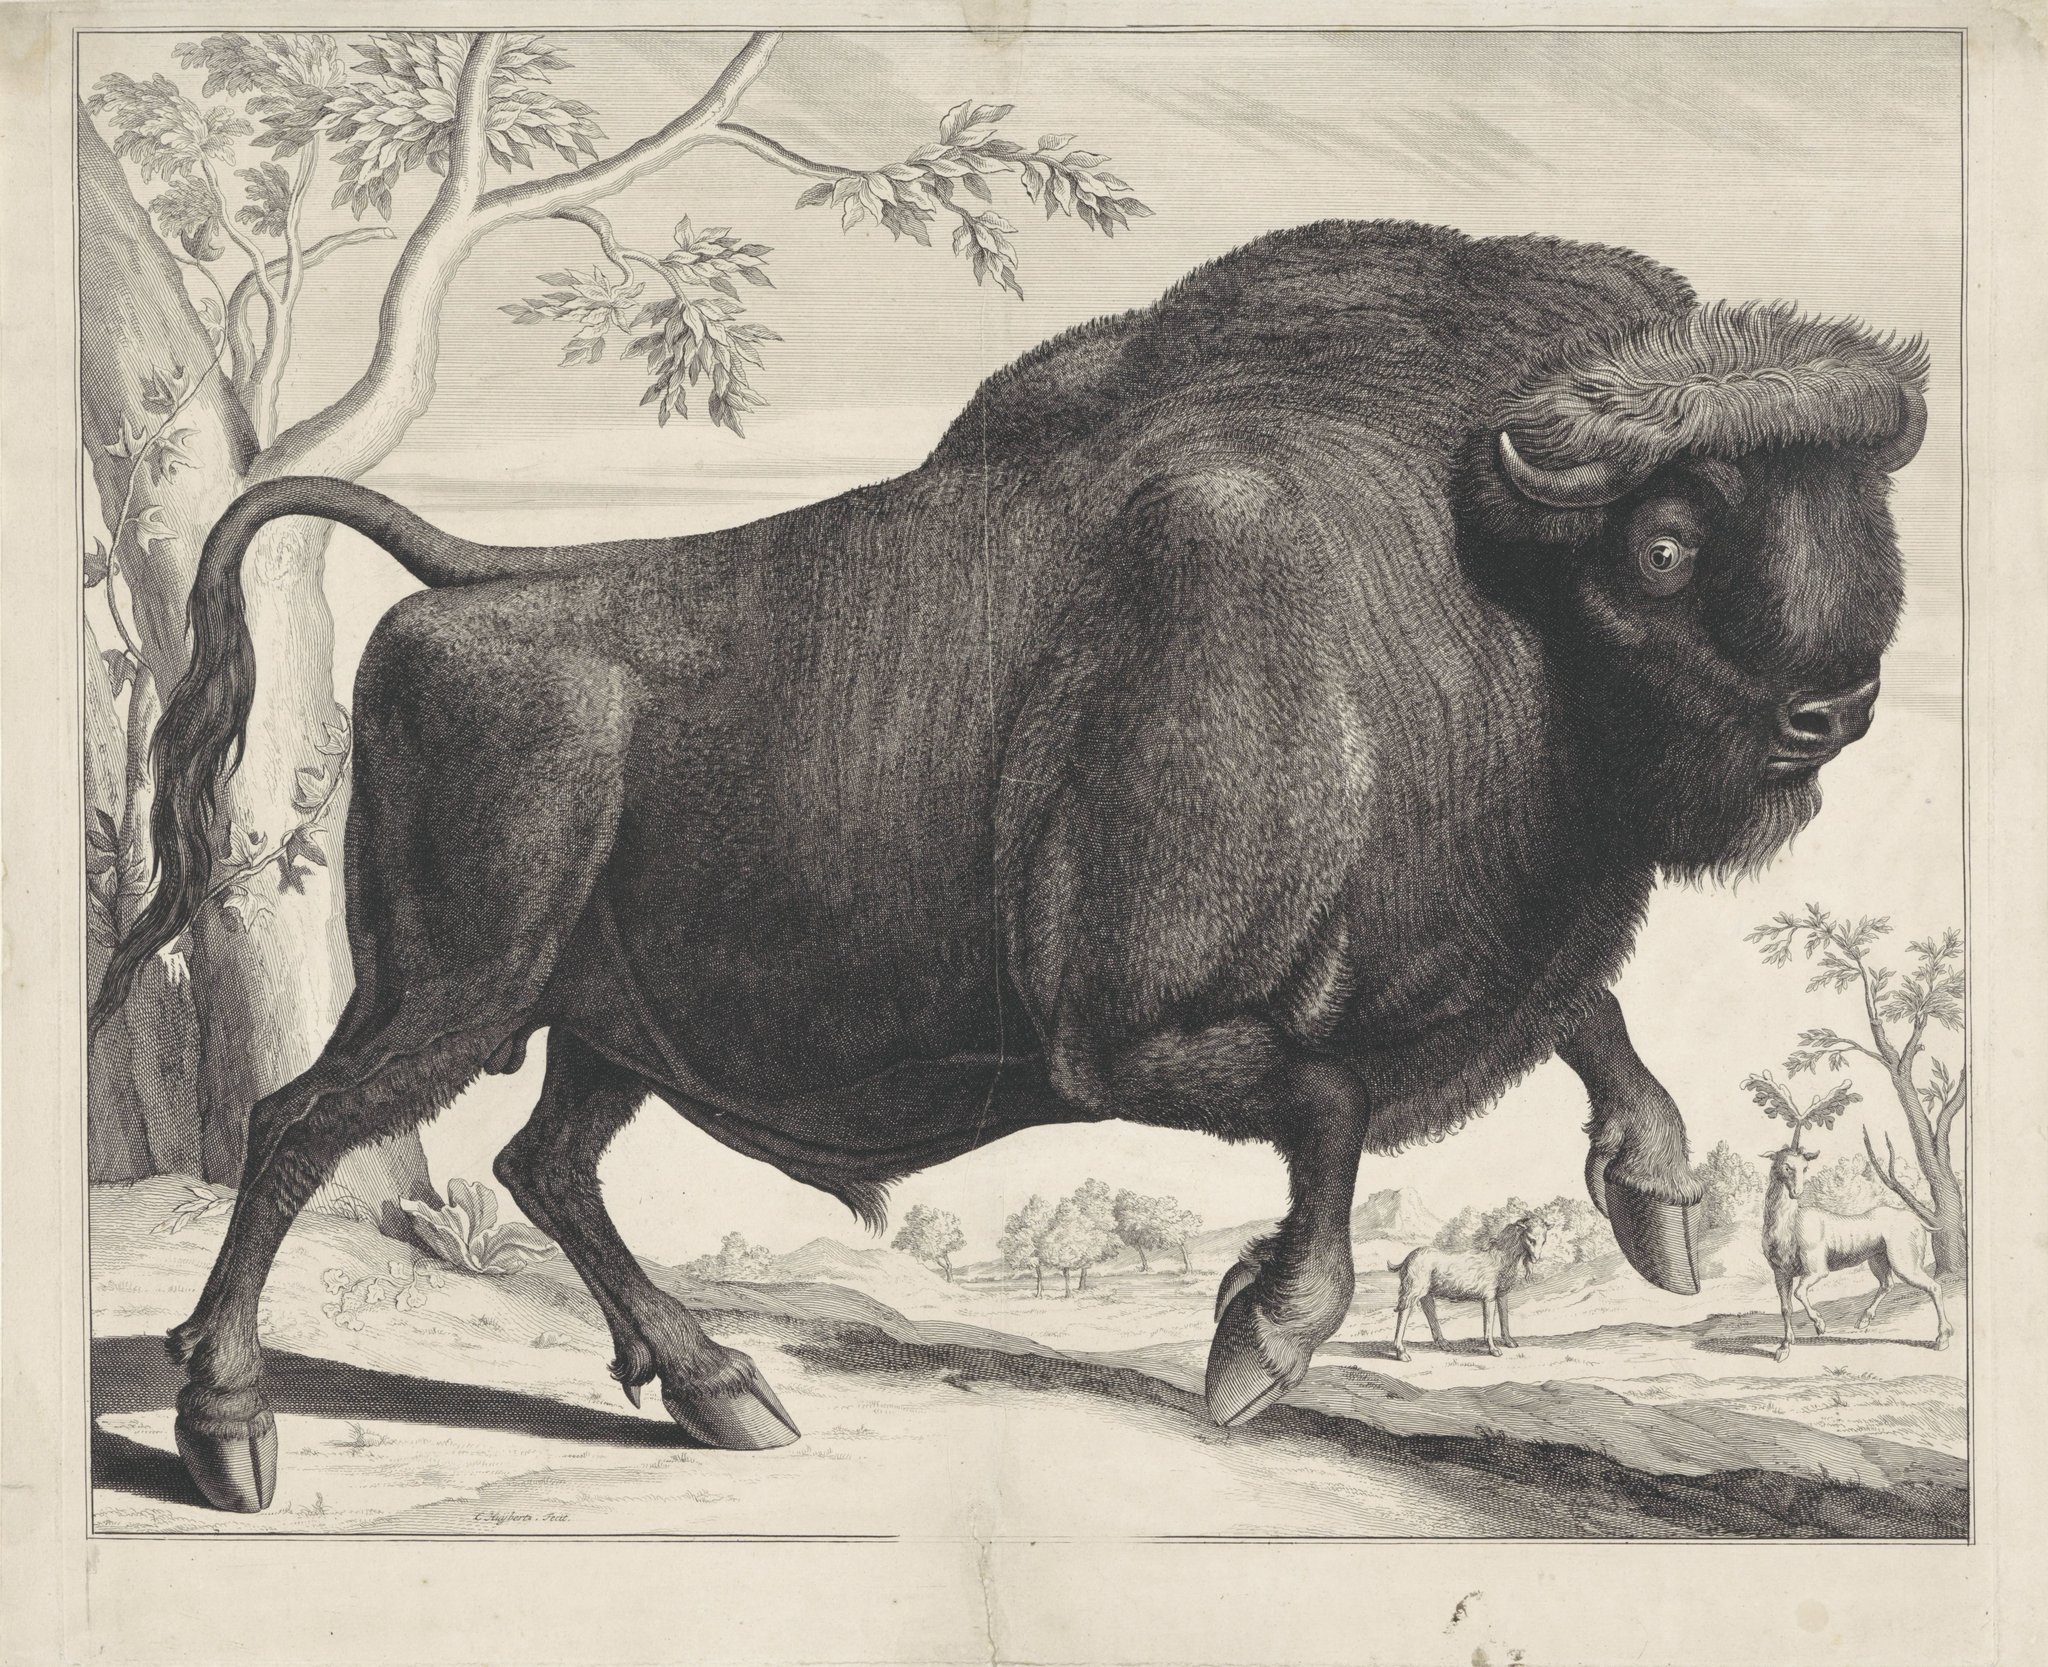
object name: print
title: Bizon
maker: cornelis huyberts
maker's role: print maker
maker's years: 1669-1709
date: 1689-1712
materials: paper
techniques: engraving, etching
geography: amsterdam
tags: fabulous animals ~ hoofed animals, hoofed animals: bison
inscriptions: collector's mark: Lugt 240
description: Ook gebruikt in: Samuel Clarke (red.), 'C. Julii Caesaris que Extant', Londen (Jacob Tonson), ca. 1712